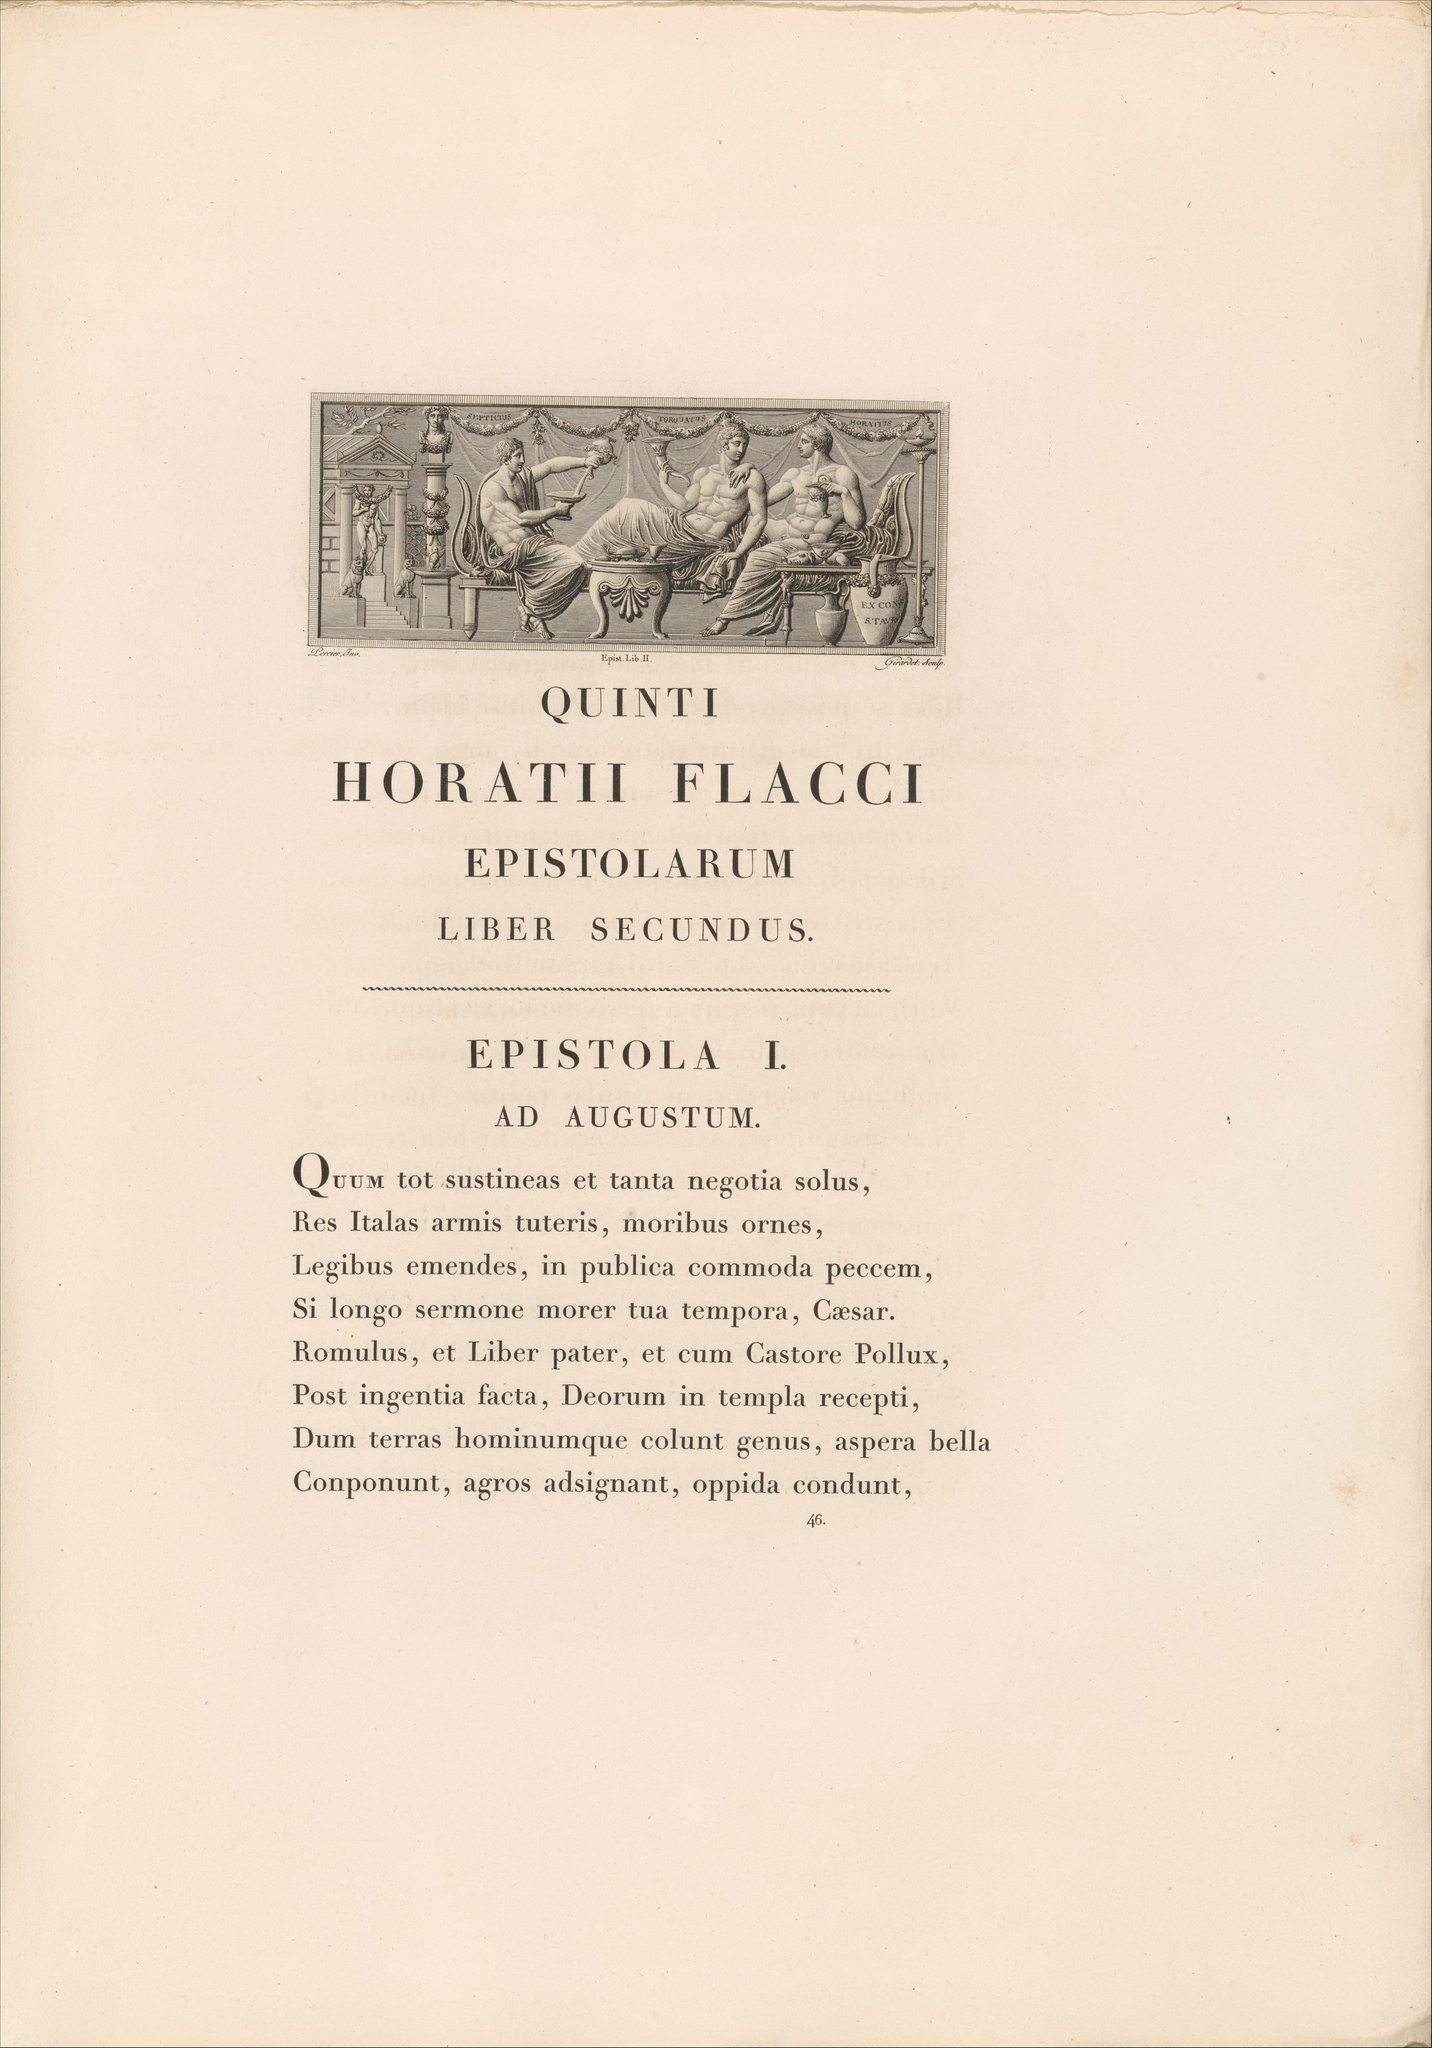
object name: book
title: Opera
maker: horace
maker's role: author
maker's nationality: roman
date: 1799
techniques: engraving, printing